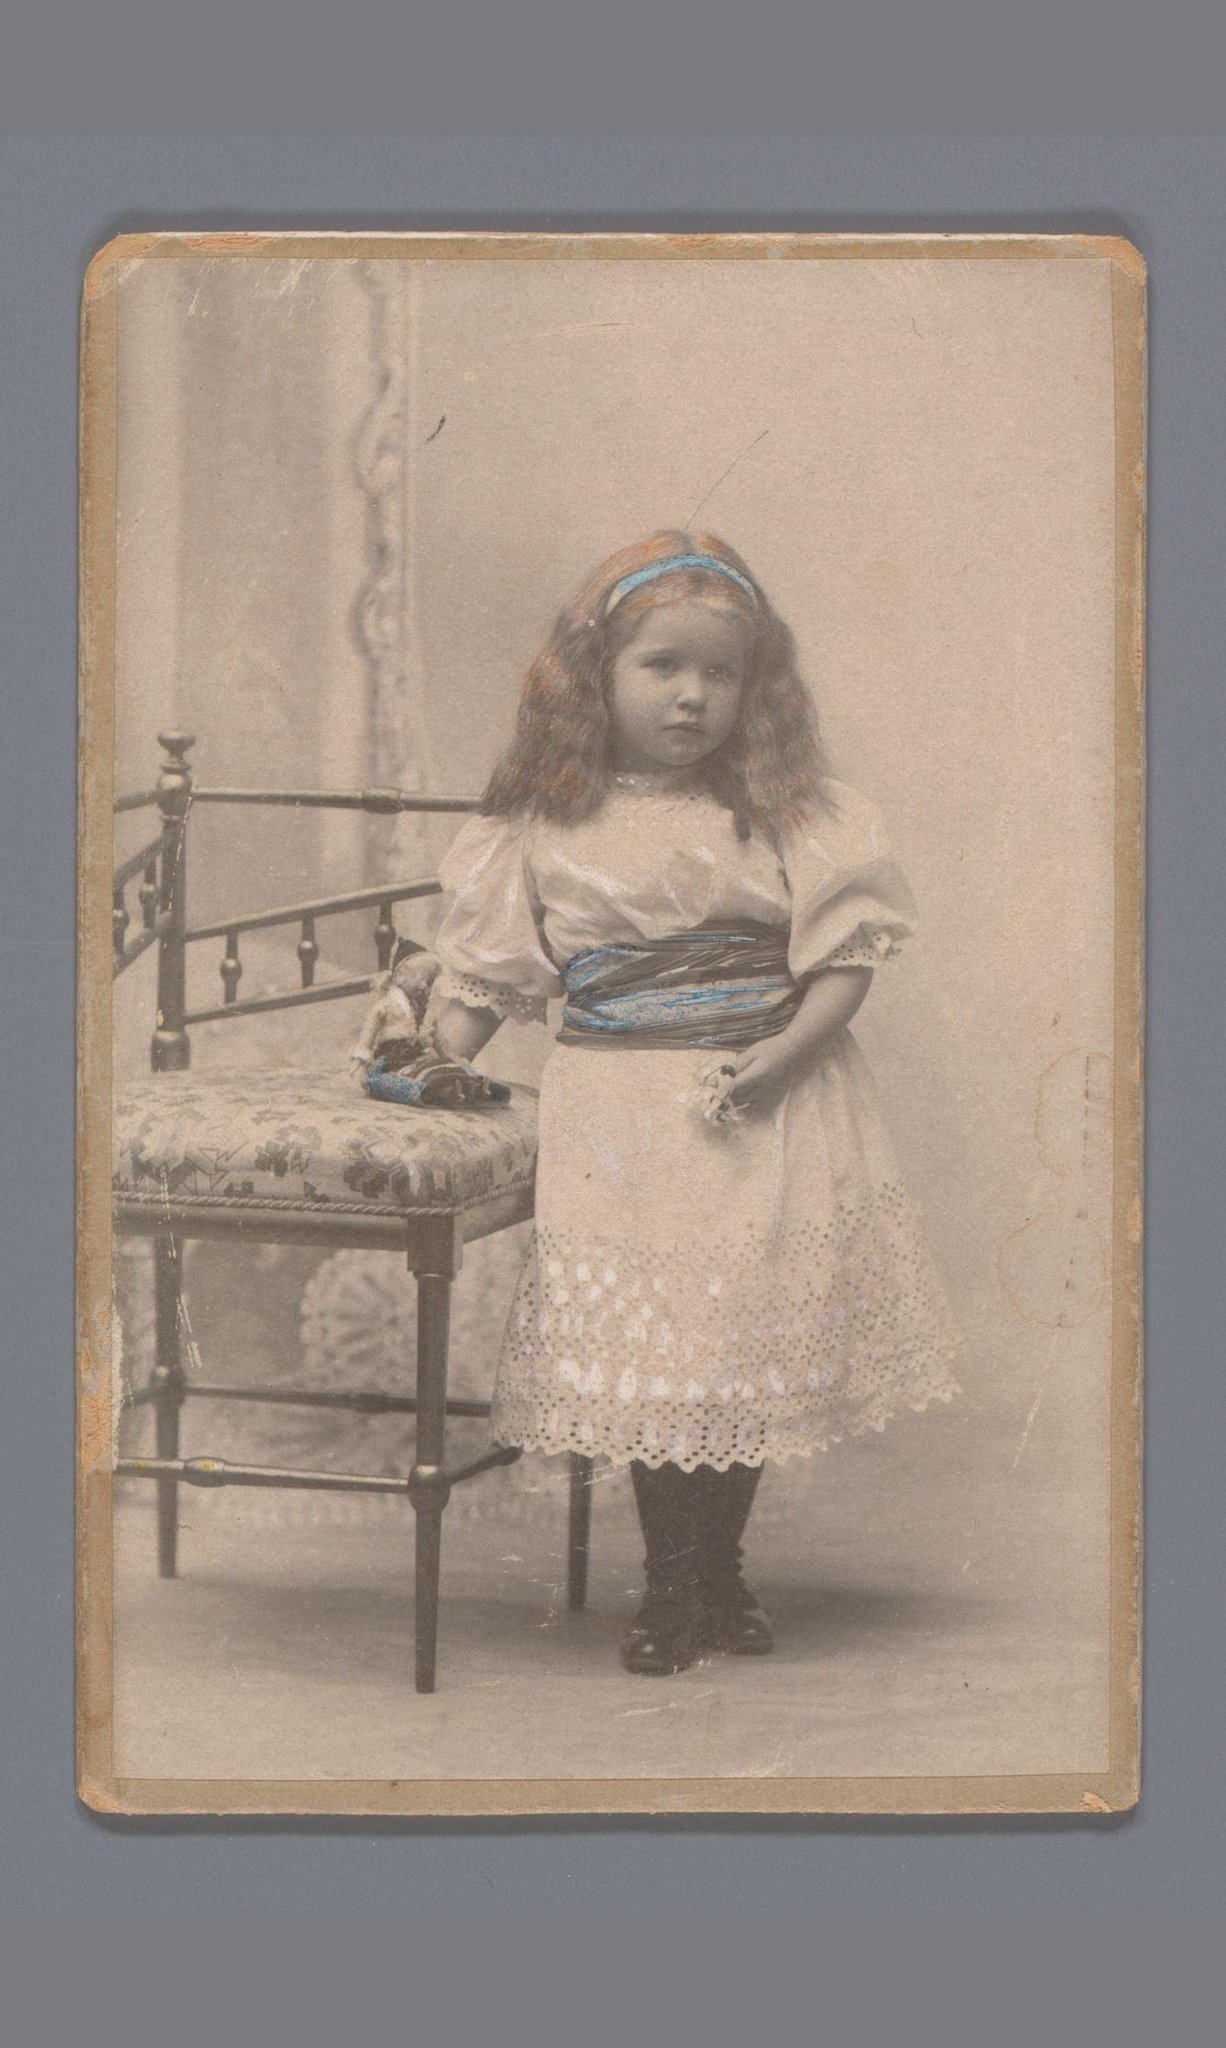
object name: carte de visite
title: Portret van een onbekend meisje, staande naast een stoel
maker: frans gustaf klemming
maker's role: fotograaf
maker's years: 1859-1922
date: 1891-1910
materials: cardboard, paper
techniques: albumen print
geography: stockholm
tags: girl (child between toddler and youth), anonymous historical person portrayed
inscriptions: inscription: ‘BELÖNAD MED/ ALLM. FOTOGRAFISKA/ UTSTÄLLNINGENS 189’